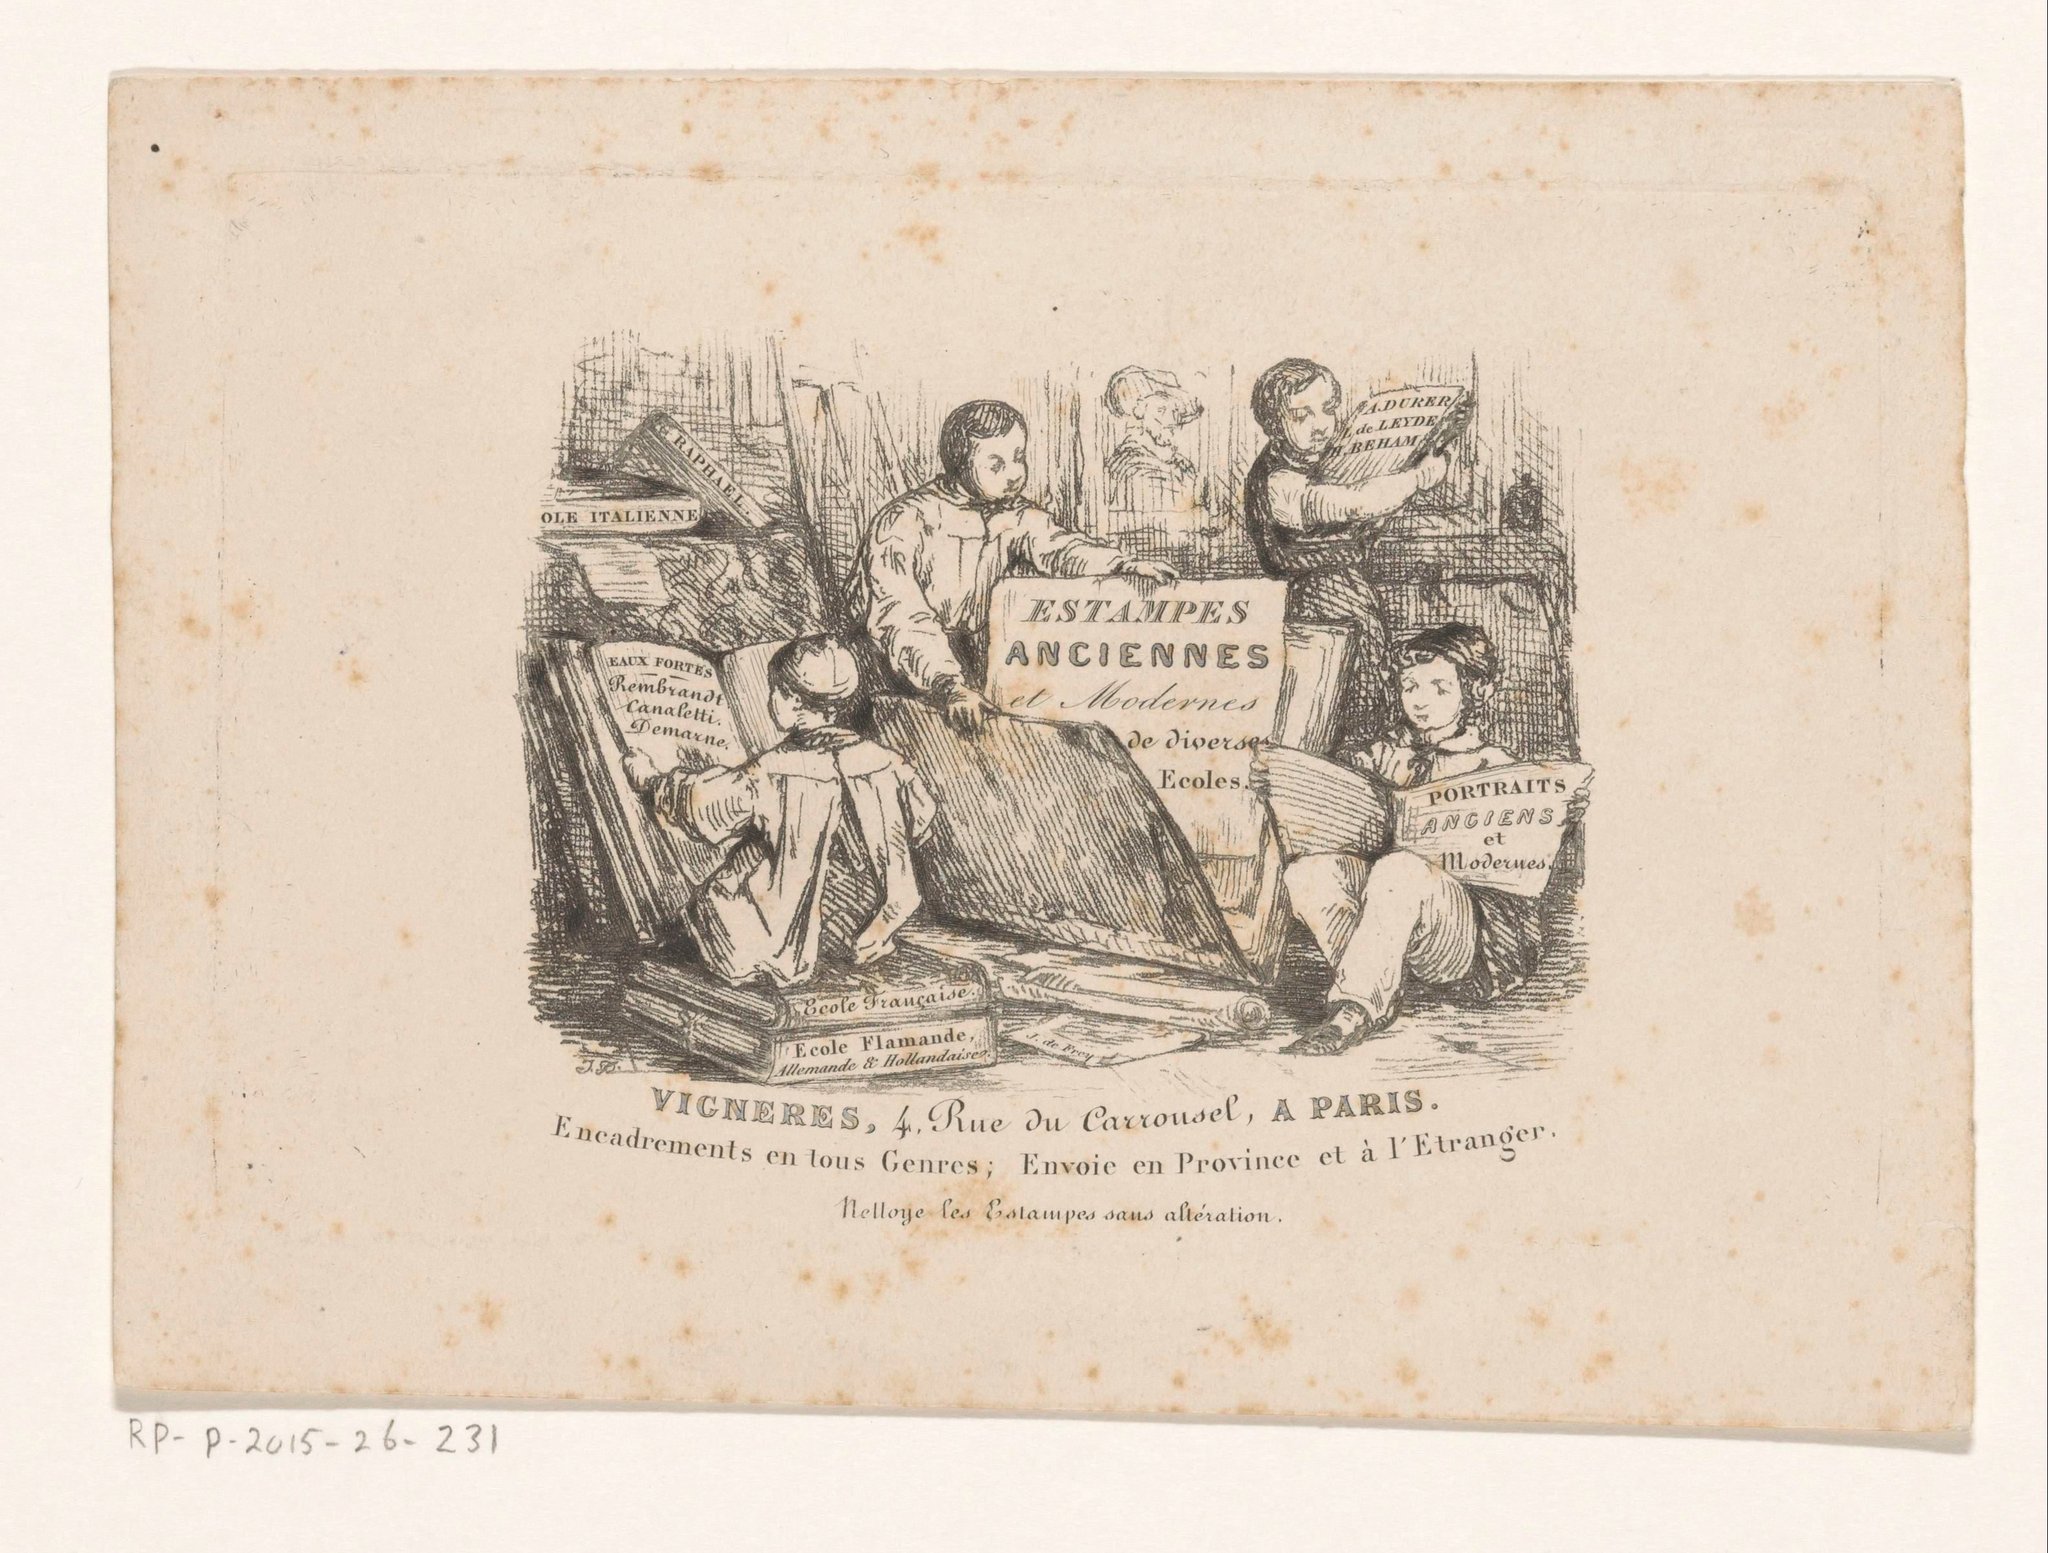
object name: print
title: Visitekaartje van prenthandel Jean-Eugène Vignères te Parijs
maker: jules porreau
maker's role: print maker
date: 1840-1850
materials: paper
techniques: engraving, soft ground etching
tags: art dealer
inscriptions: collector's mark: Lugt 2228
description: Interieur van een prenthandel. Twee mannen en twee jongens bladeren door albums en portfolio's waar de namen van verschillende kunstenaars of scholen op vermeld zijn. Naast prenthandelaar was Vignères ook uitgever en expert bij veilingen.